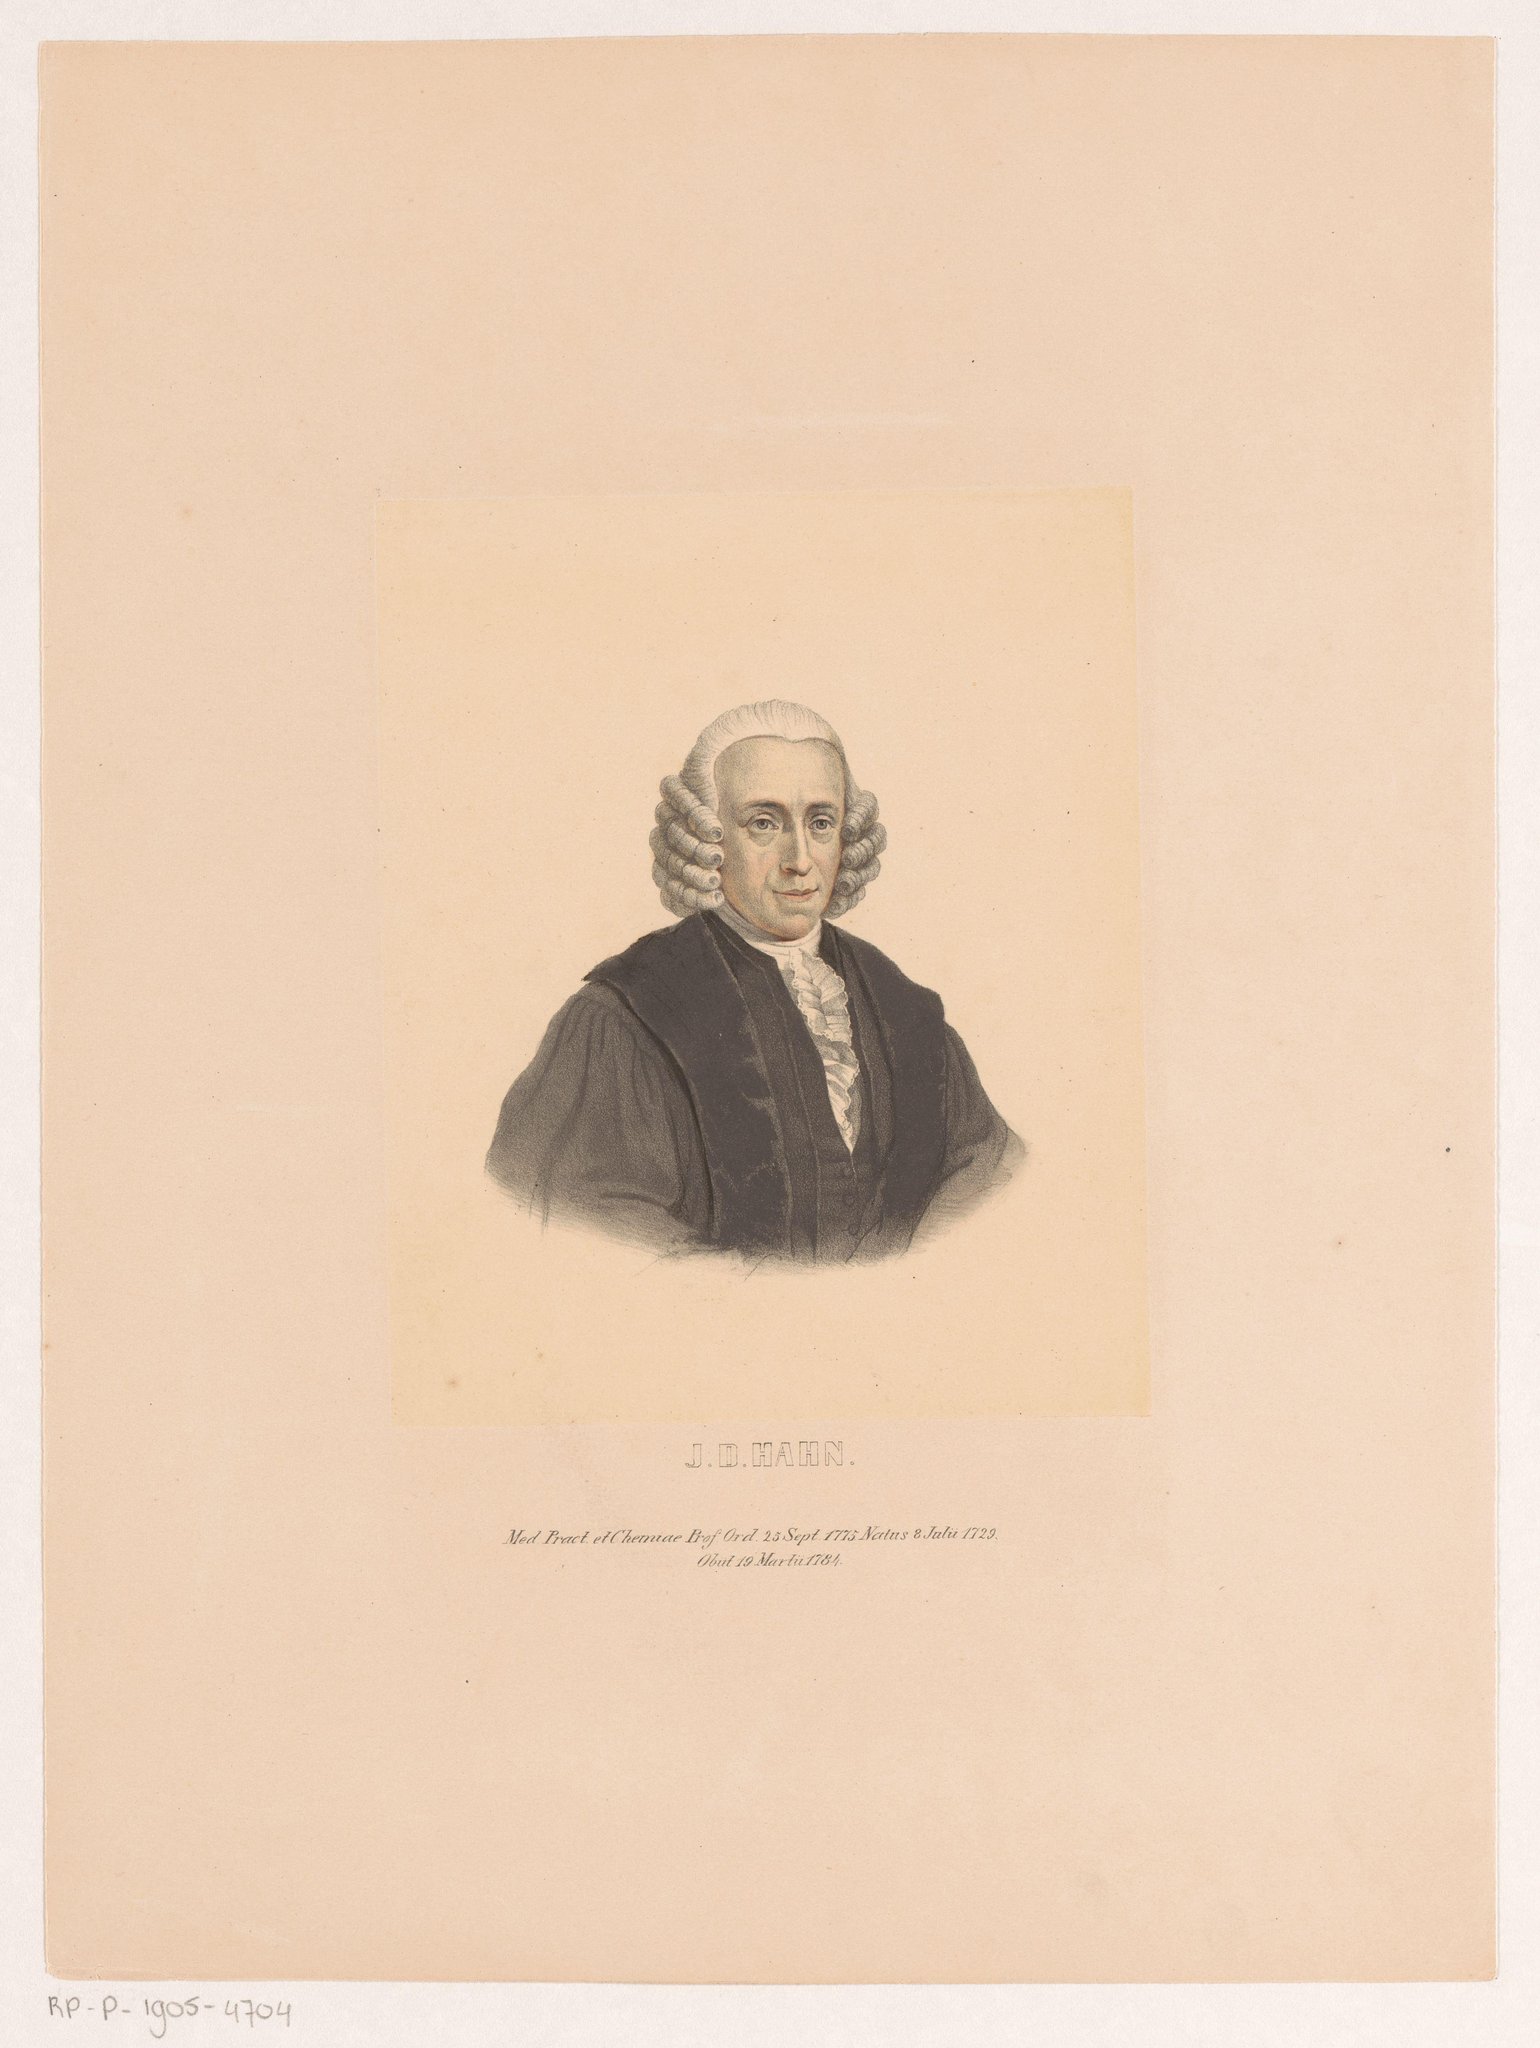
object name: print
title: J.D. Hahn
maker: leendert springer (i)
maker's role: draughtsman, painter, print maker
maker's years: 1789-1871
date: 1850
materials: paper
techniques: lithograph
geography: leiden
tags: historical persons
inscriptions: collector's mark: Lugt 2228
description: Prent uit: Springer, Leendert. Galerij van hoogleeraren aan de Hoogeschool te Leijden, naar de oorspronkelijke afbeeldsels op de Senaat-zaal aldaar berustende. Leiden: Springer, Leendert., s.a. [circa 1850].